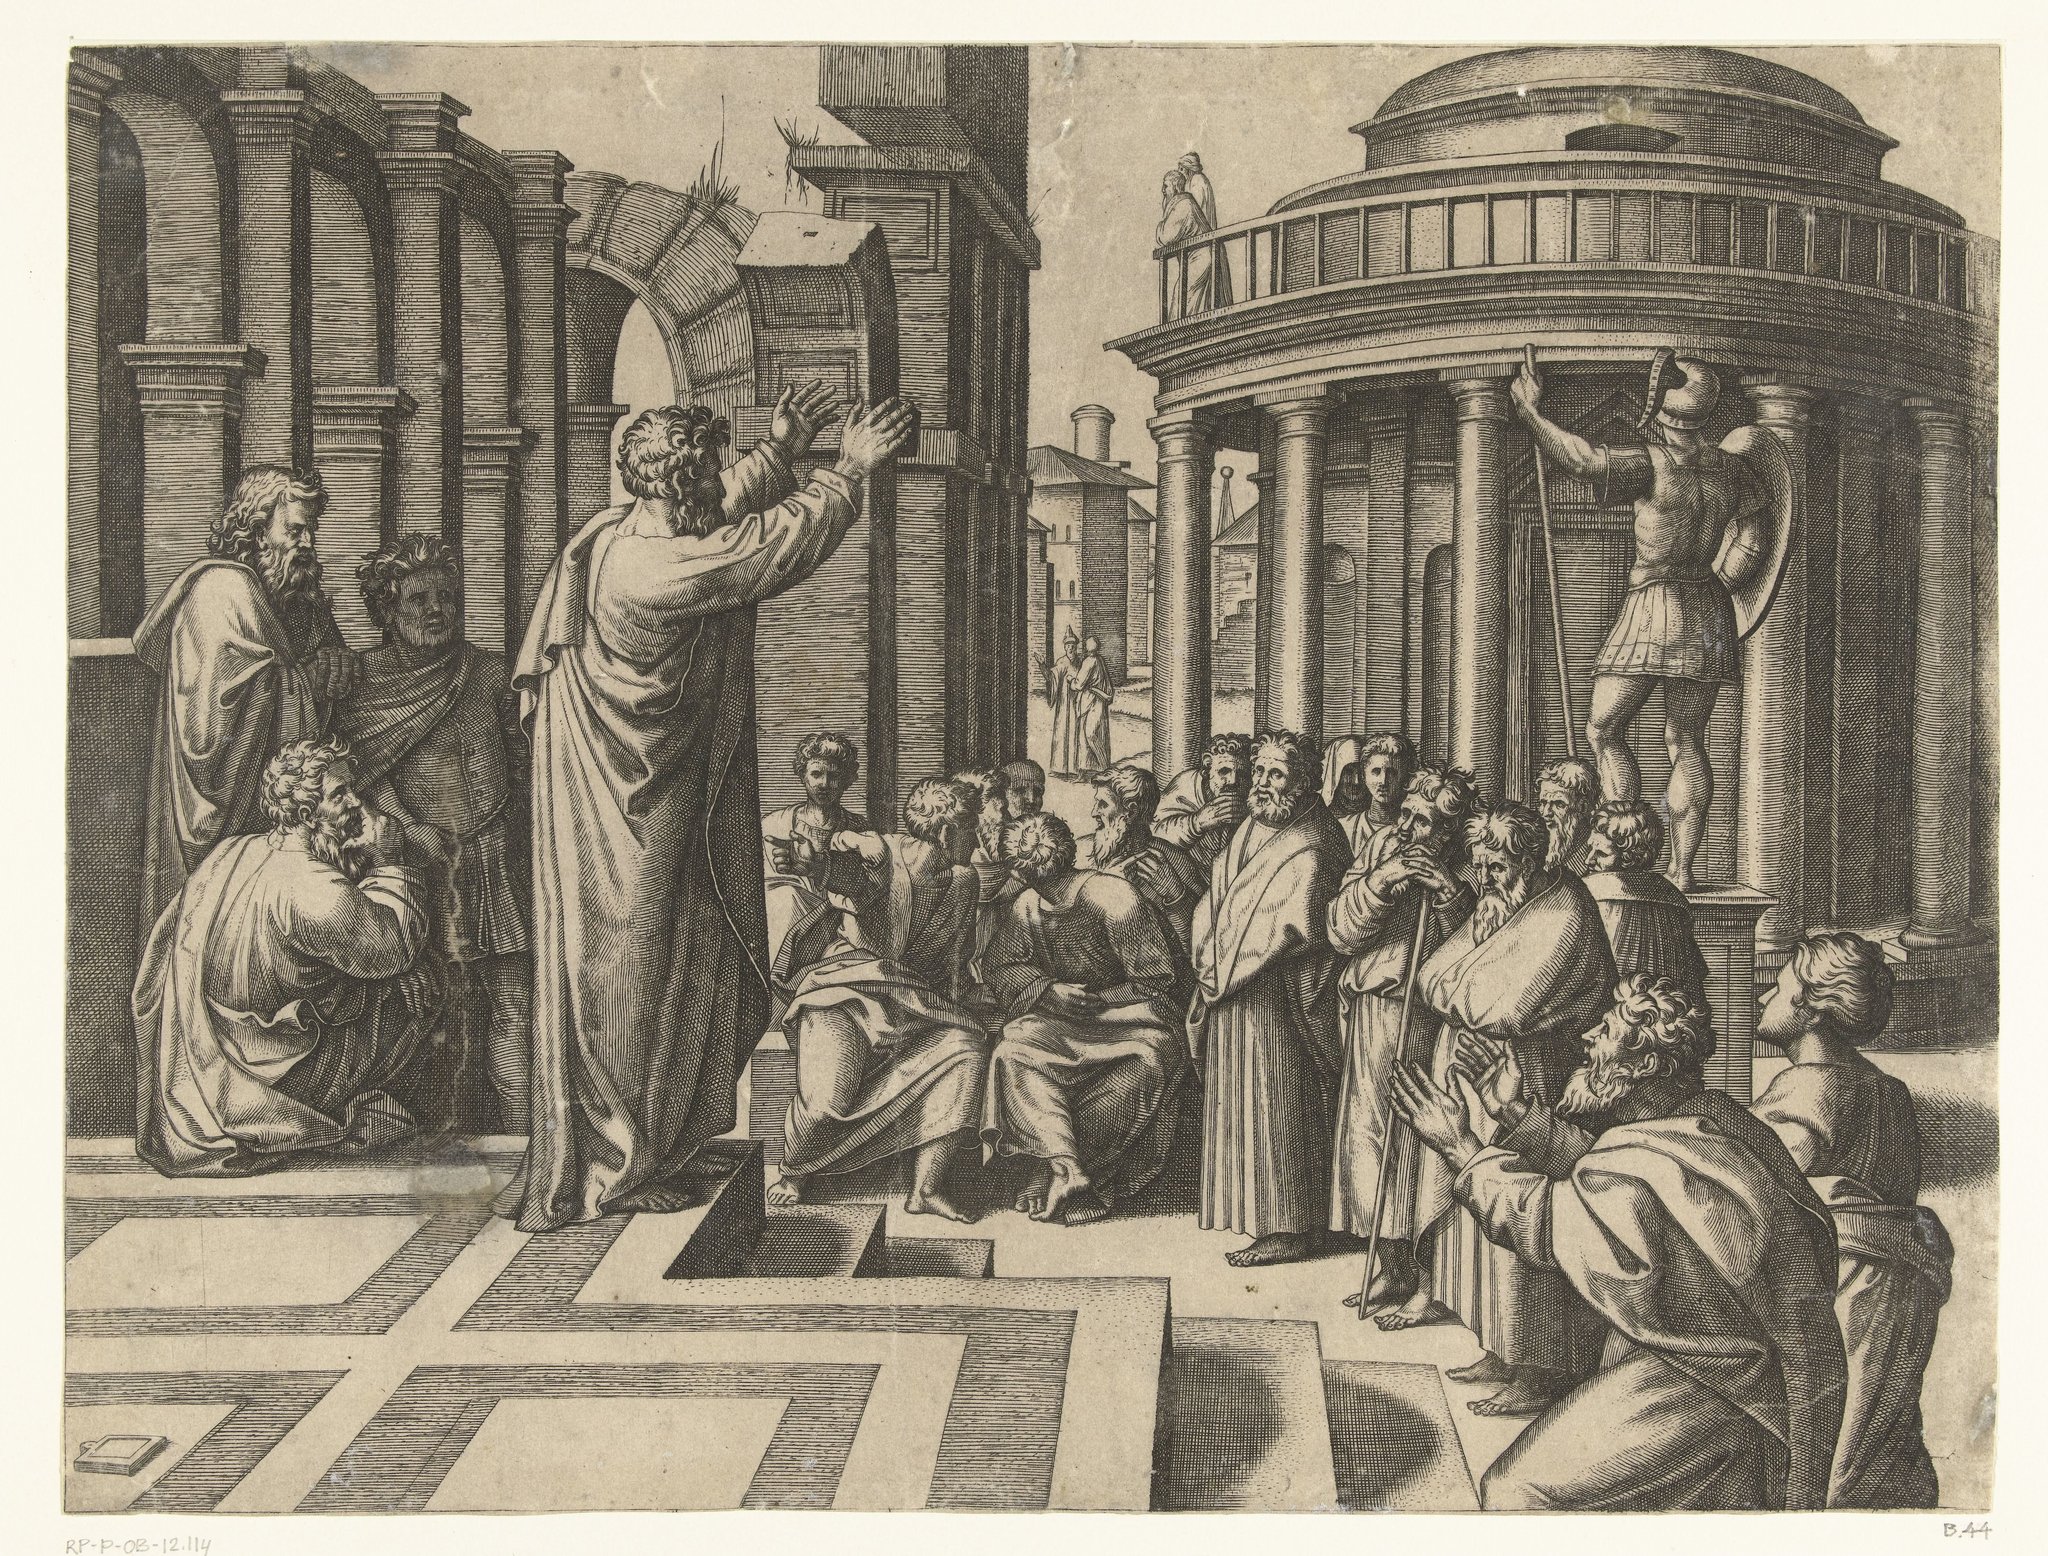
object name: print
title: Paulus predikt in Athene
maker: marcantonio raimondi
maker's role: print maker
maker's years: 1470-1534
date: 1517-1520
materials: paper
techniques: engraving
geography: italy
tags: paul in athens: on the areopagus he discusses with philosophers (in front of the temple of mars)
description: Paulus predikt in Athene voor de areopagus, het hoogste Atheense gerechtscollege. Op de voorgrond bekeert Dionysius de Areopagiet zich tot het christendom.